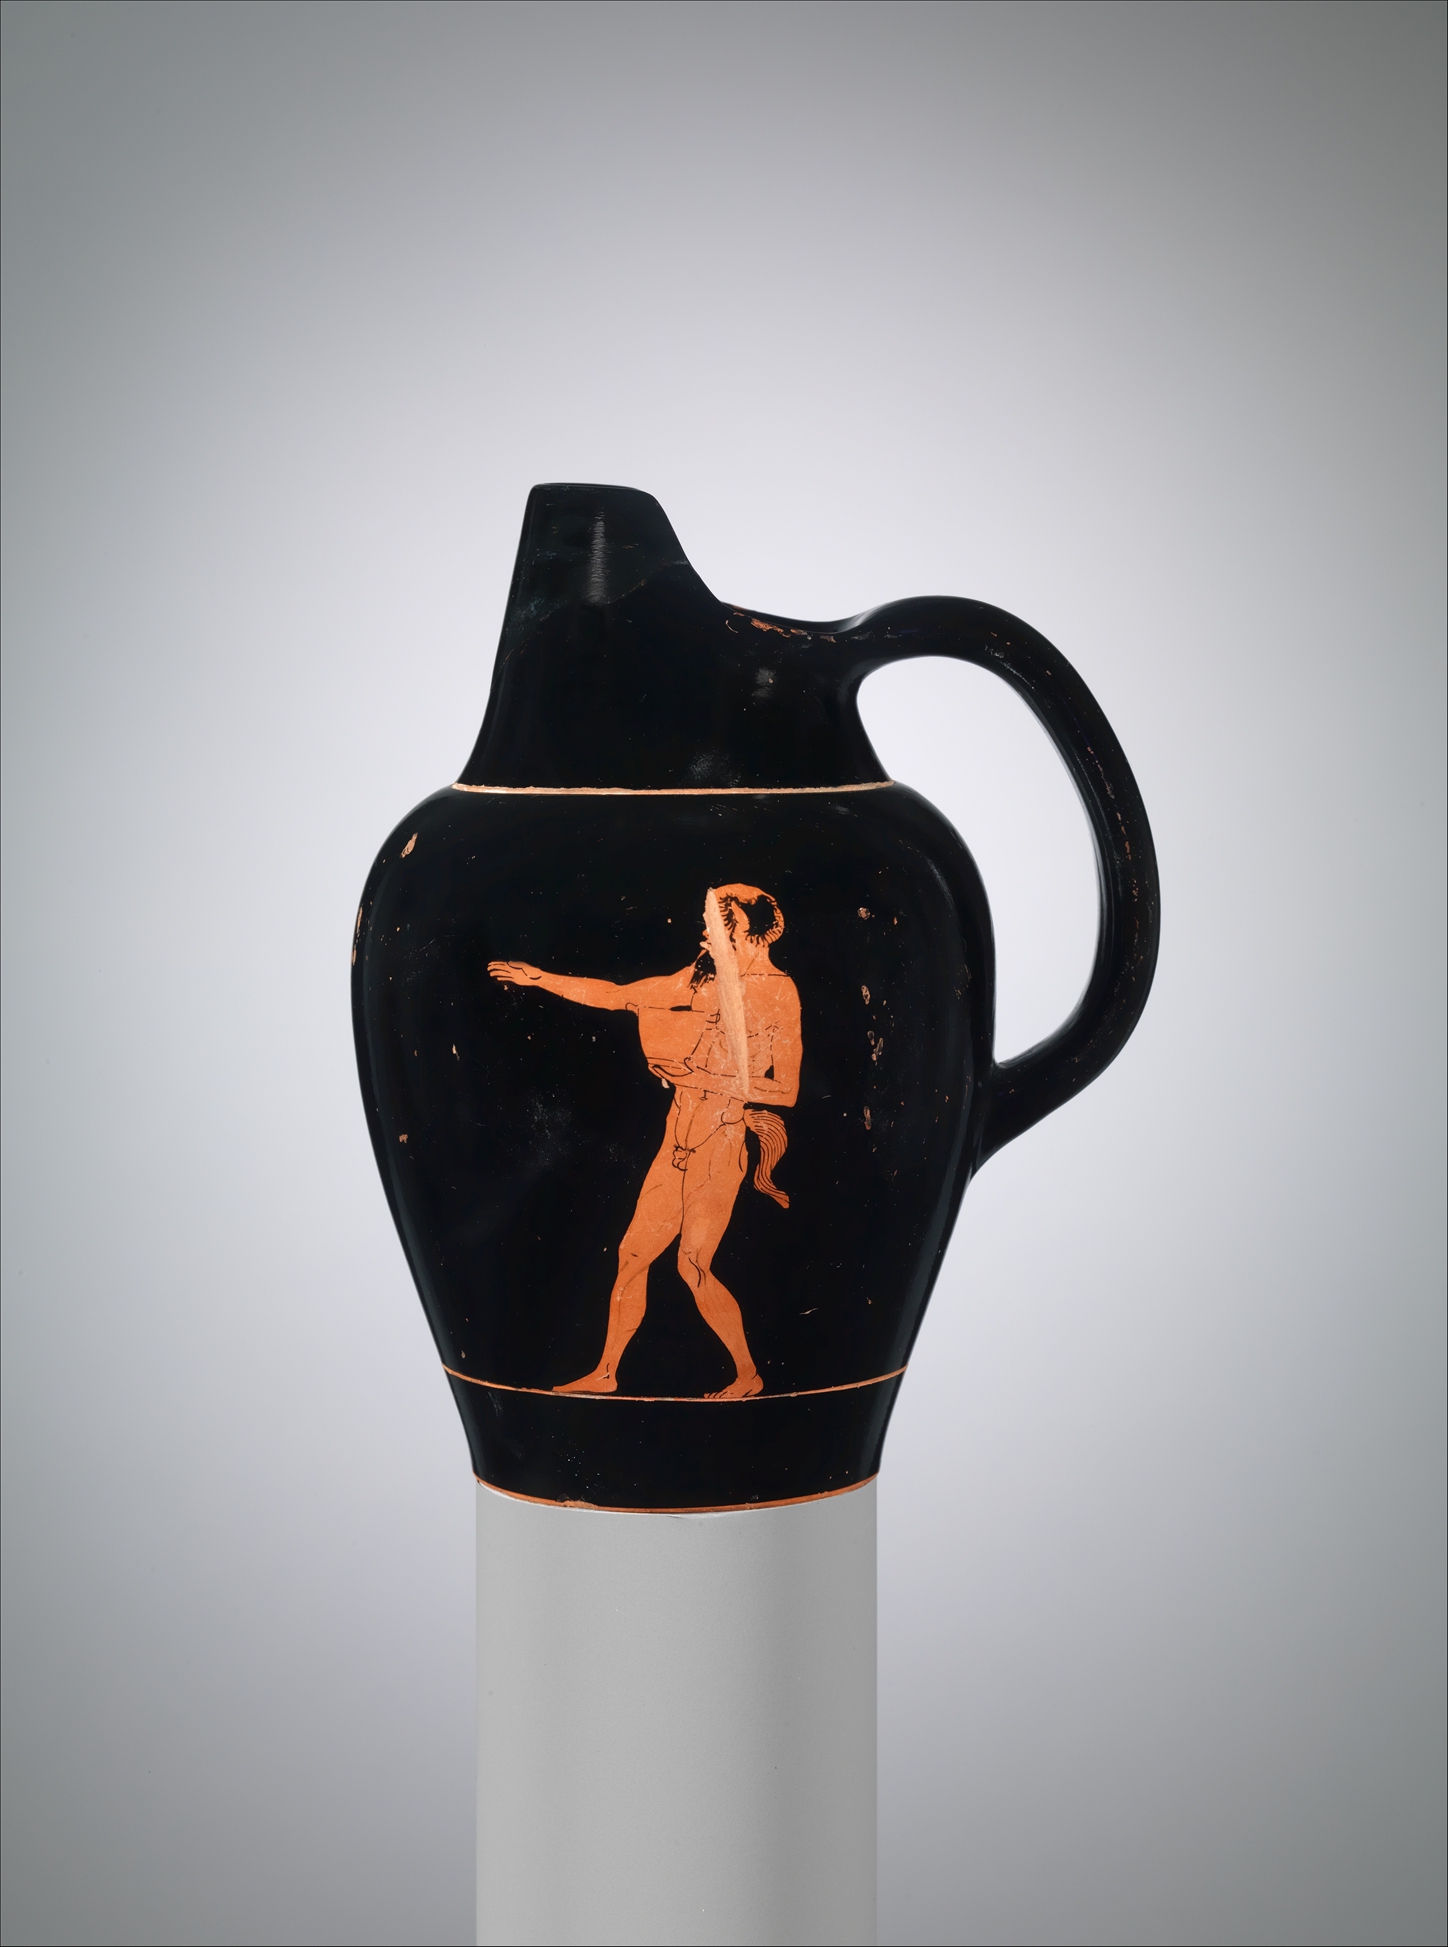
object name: oinochoe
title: Terracotta oinochoe (jug)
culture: greek, attic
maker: painter of louvre ca 1694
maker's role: artist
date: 450 BCE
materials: terracotta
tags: male nudes,satyrs